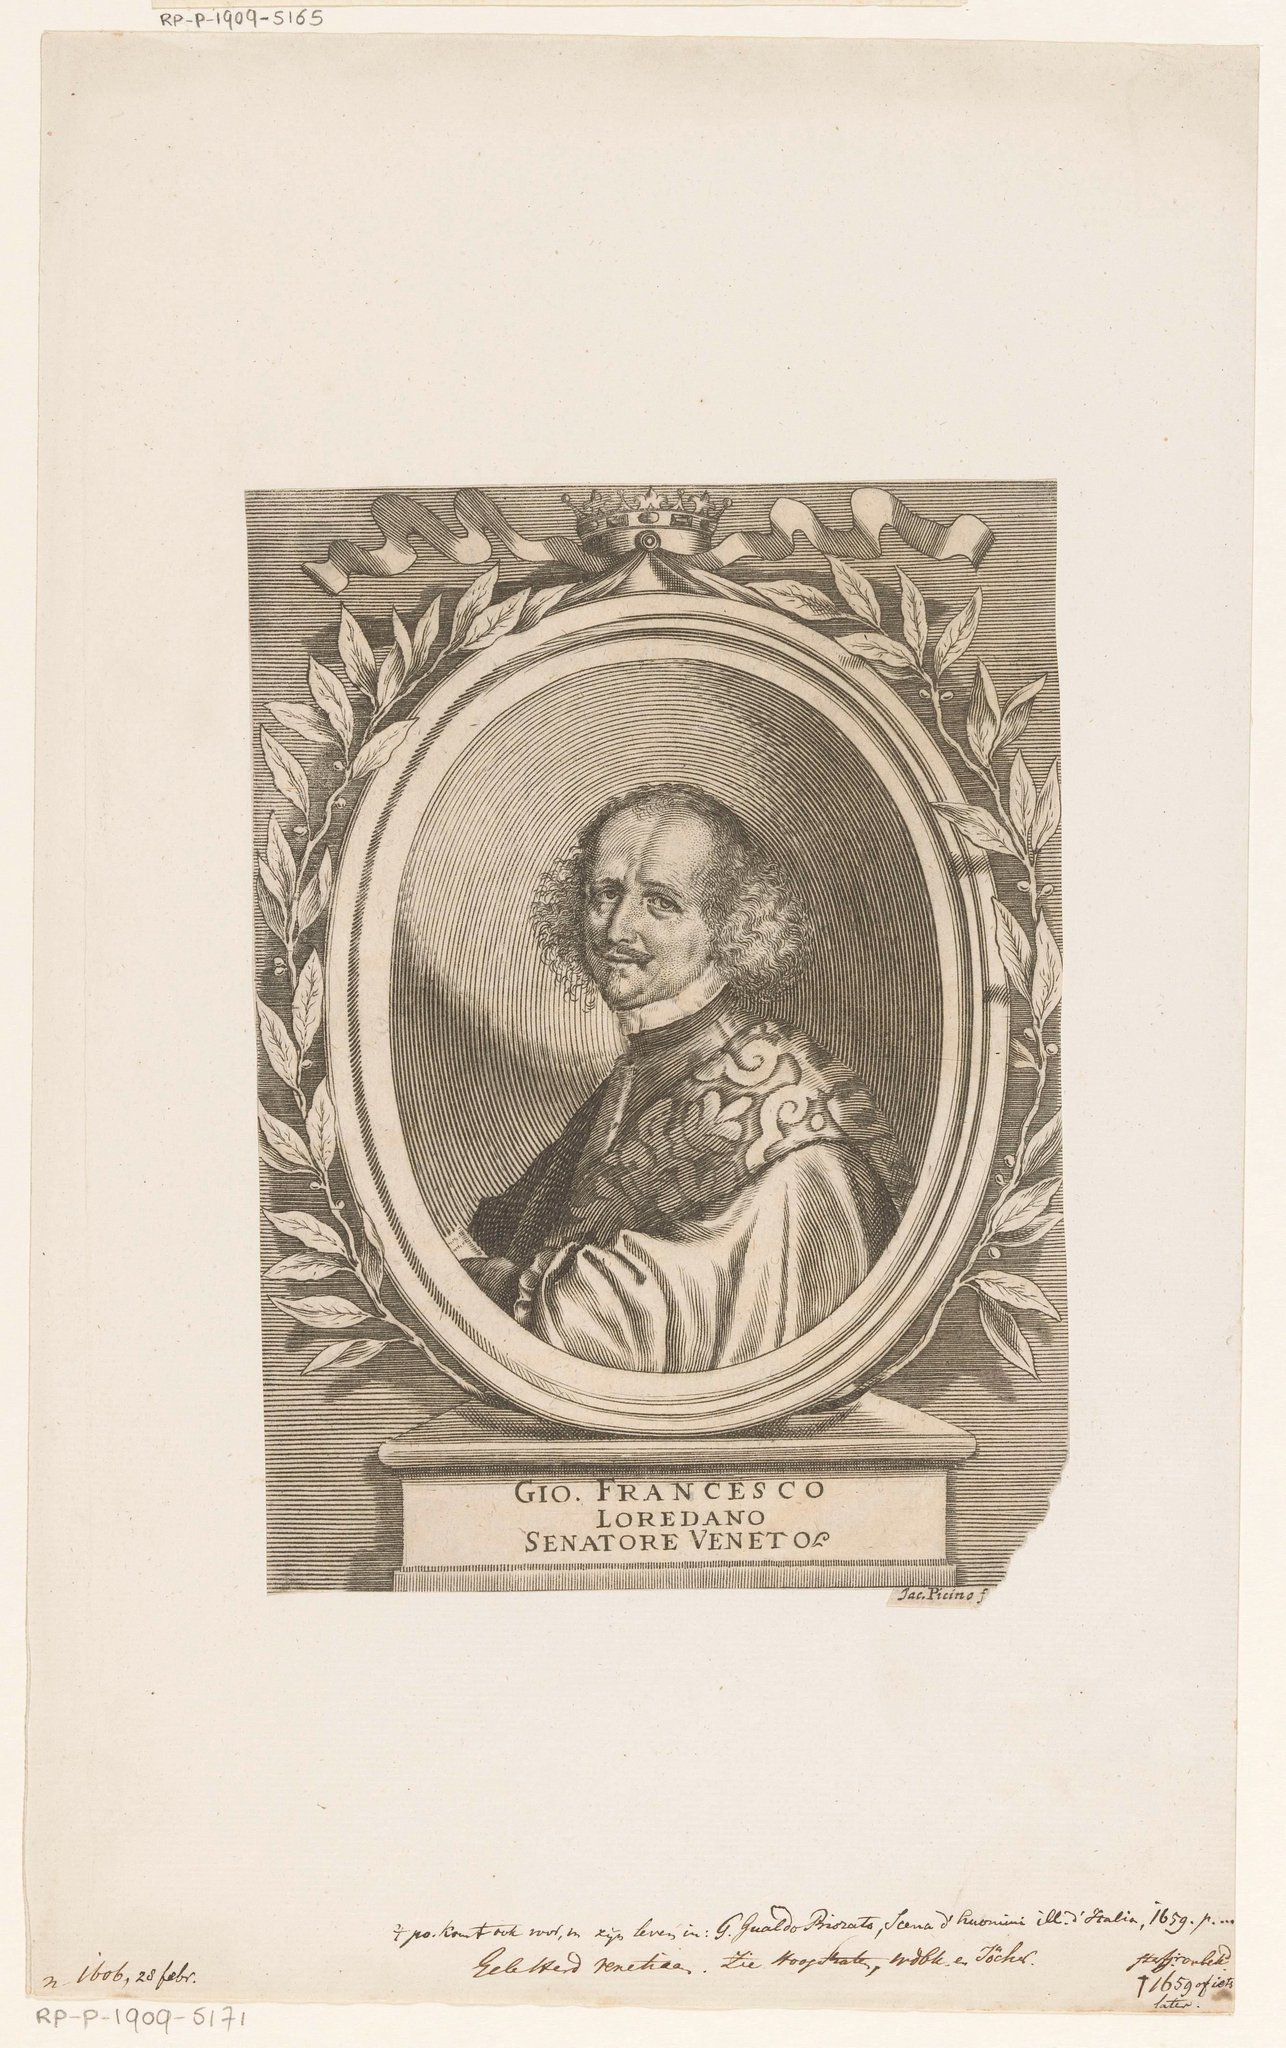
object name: book illustration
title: Portret van schrijver Giovan Francesco Loredan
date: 1659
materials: paper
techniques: engraving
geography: venice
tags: venice, historical persons, portrait of a writer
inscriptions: collector's mark: Lugt 2228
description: Prent gebruikt voor de publicatie: Priorato, Galeazzo Gualdo. Scena d'huomini illustri d'Italia. Venetië: Andrea Giuliani, 1659. Een gedeelte van de ondermarge is afgesneden en rechtsonder is de prent beschadigd.